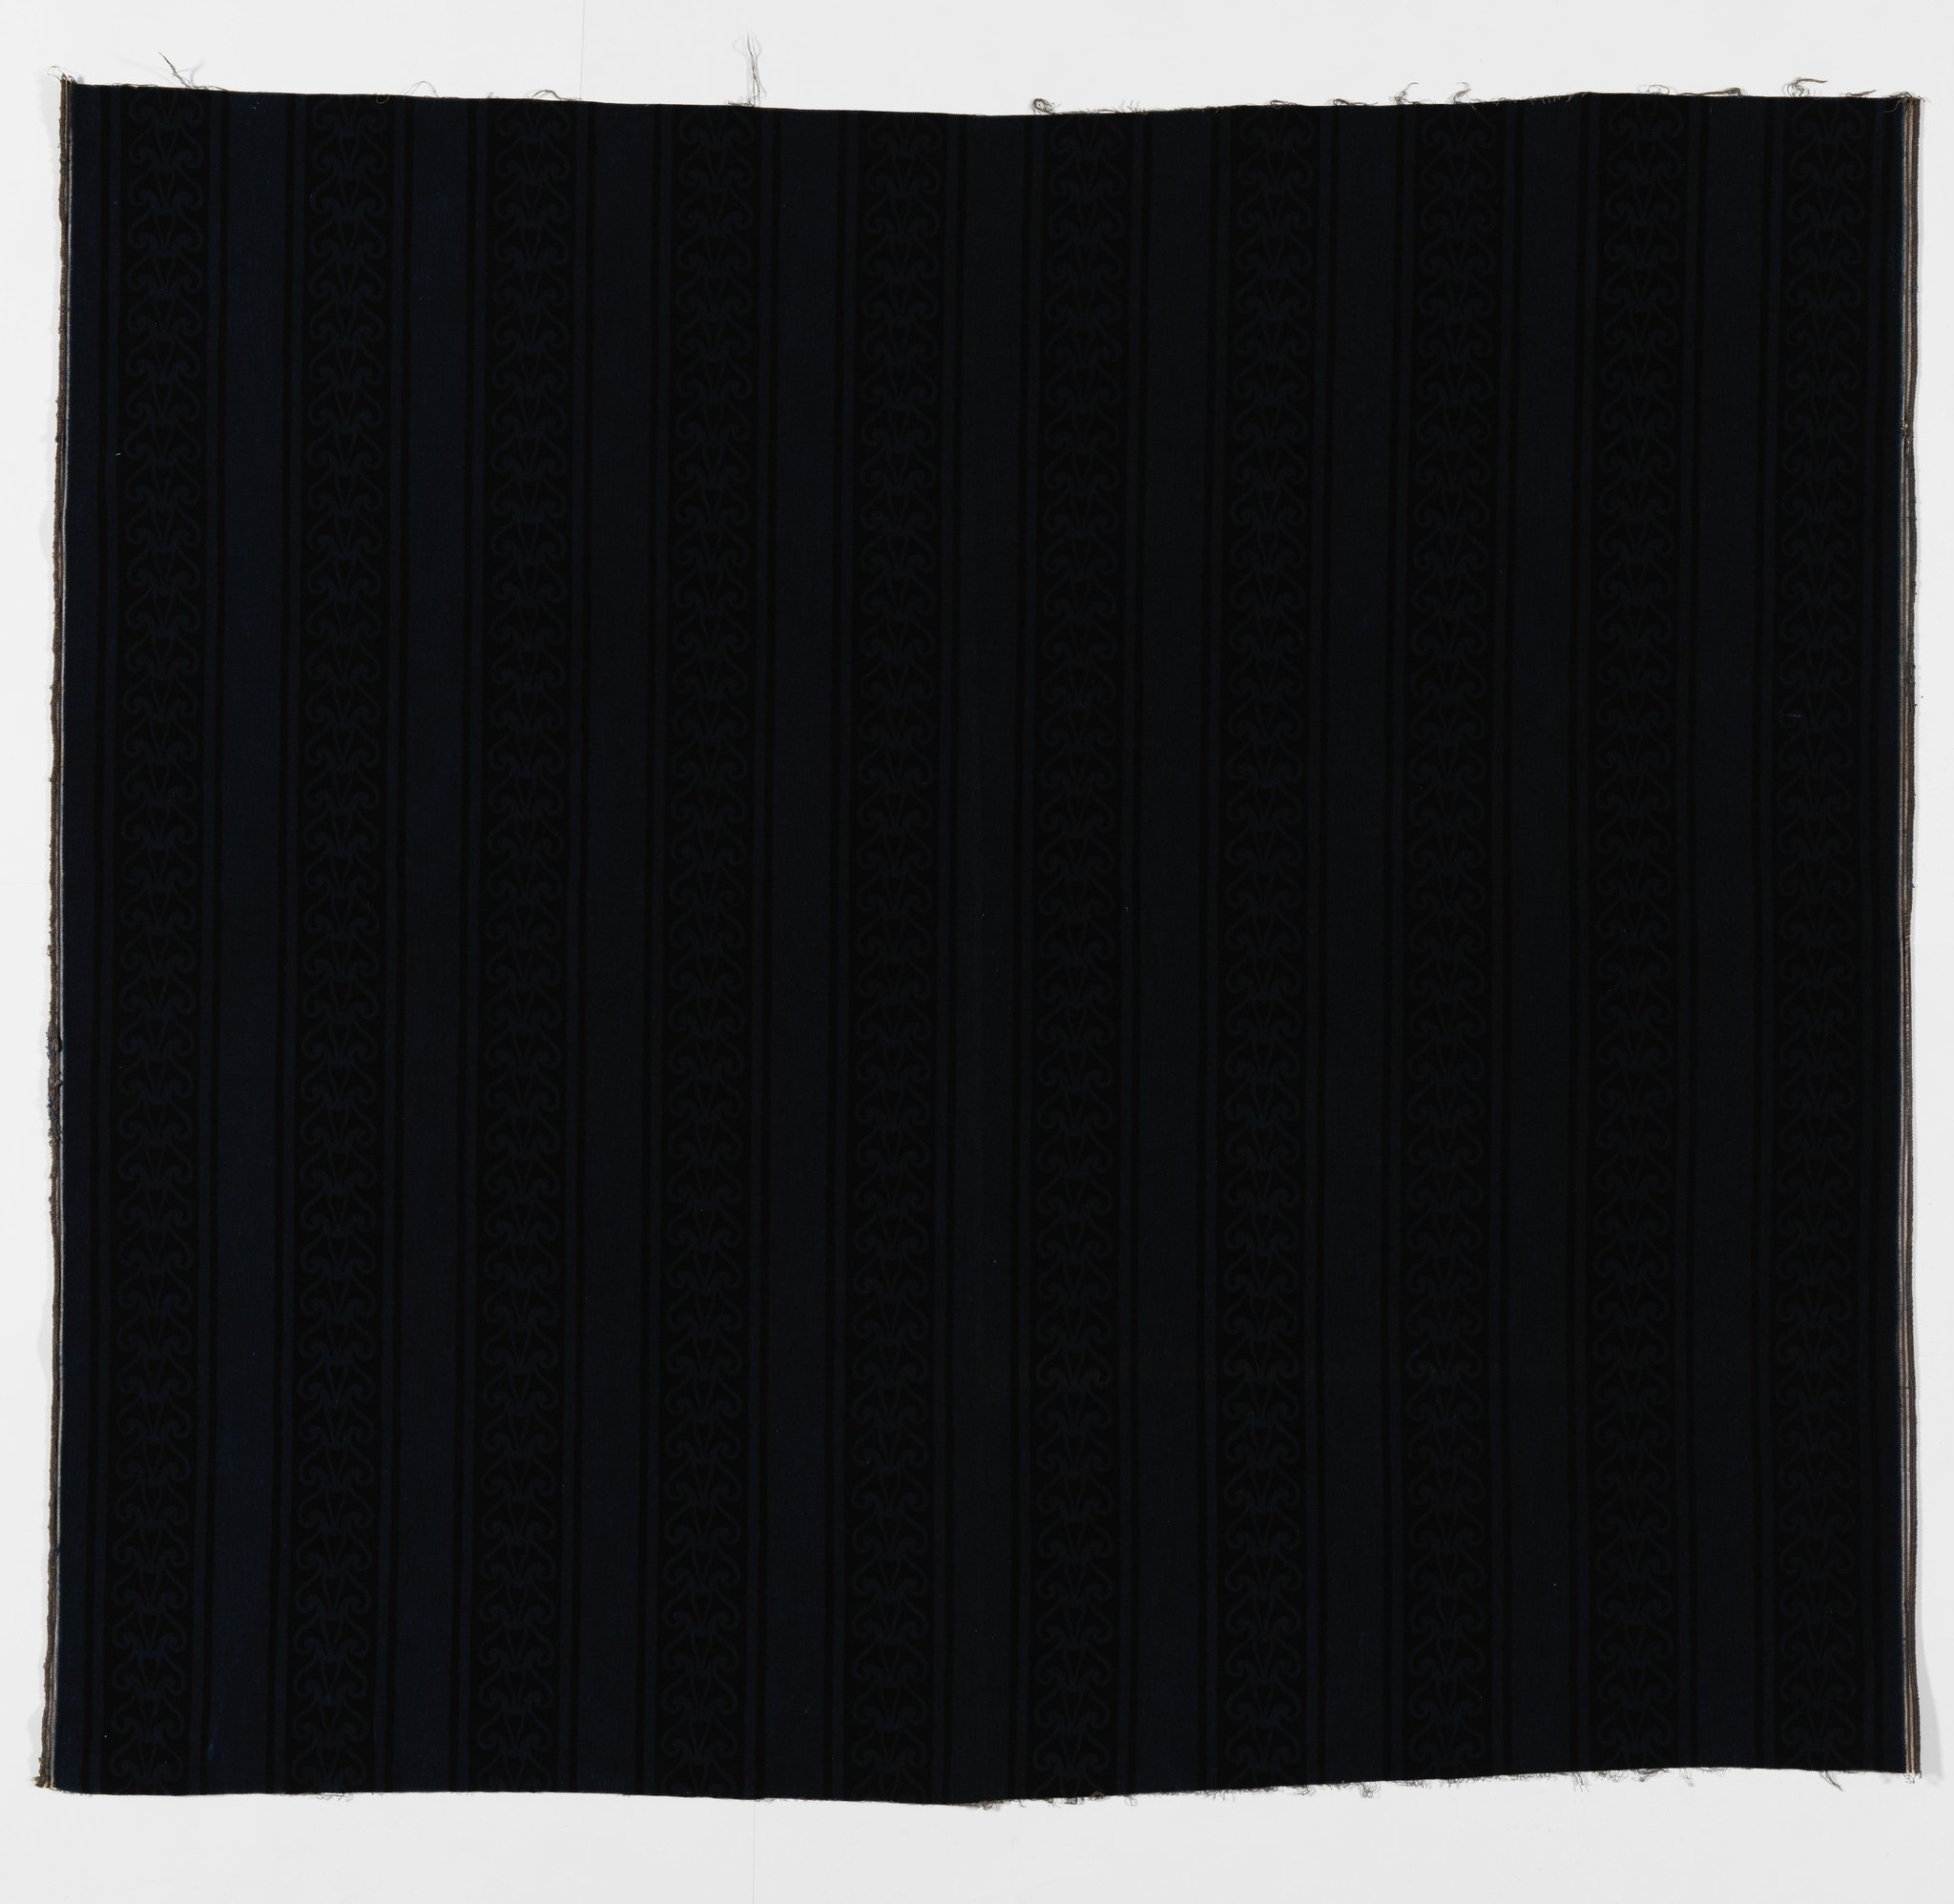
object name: upholstery fabric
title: Bedrukte trijp met patroon van verticale, geornamenteerde banen in zwart op donkerblauw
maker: jacobus hellendoorn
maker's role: architect, grafisch ontwerper, interieurontwerper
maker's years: 1887-1959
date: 1920-1930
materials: cotton, textile, hair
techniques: printing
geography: netherlands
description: Bekledings- of bespanningsstof van bedrukte trijp met patroon van verticale, geornamenteerde banen in zwart op een donkerblauwe fond.